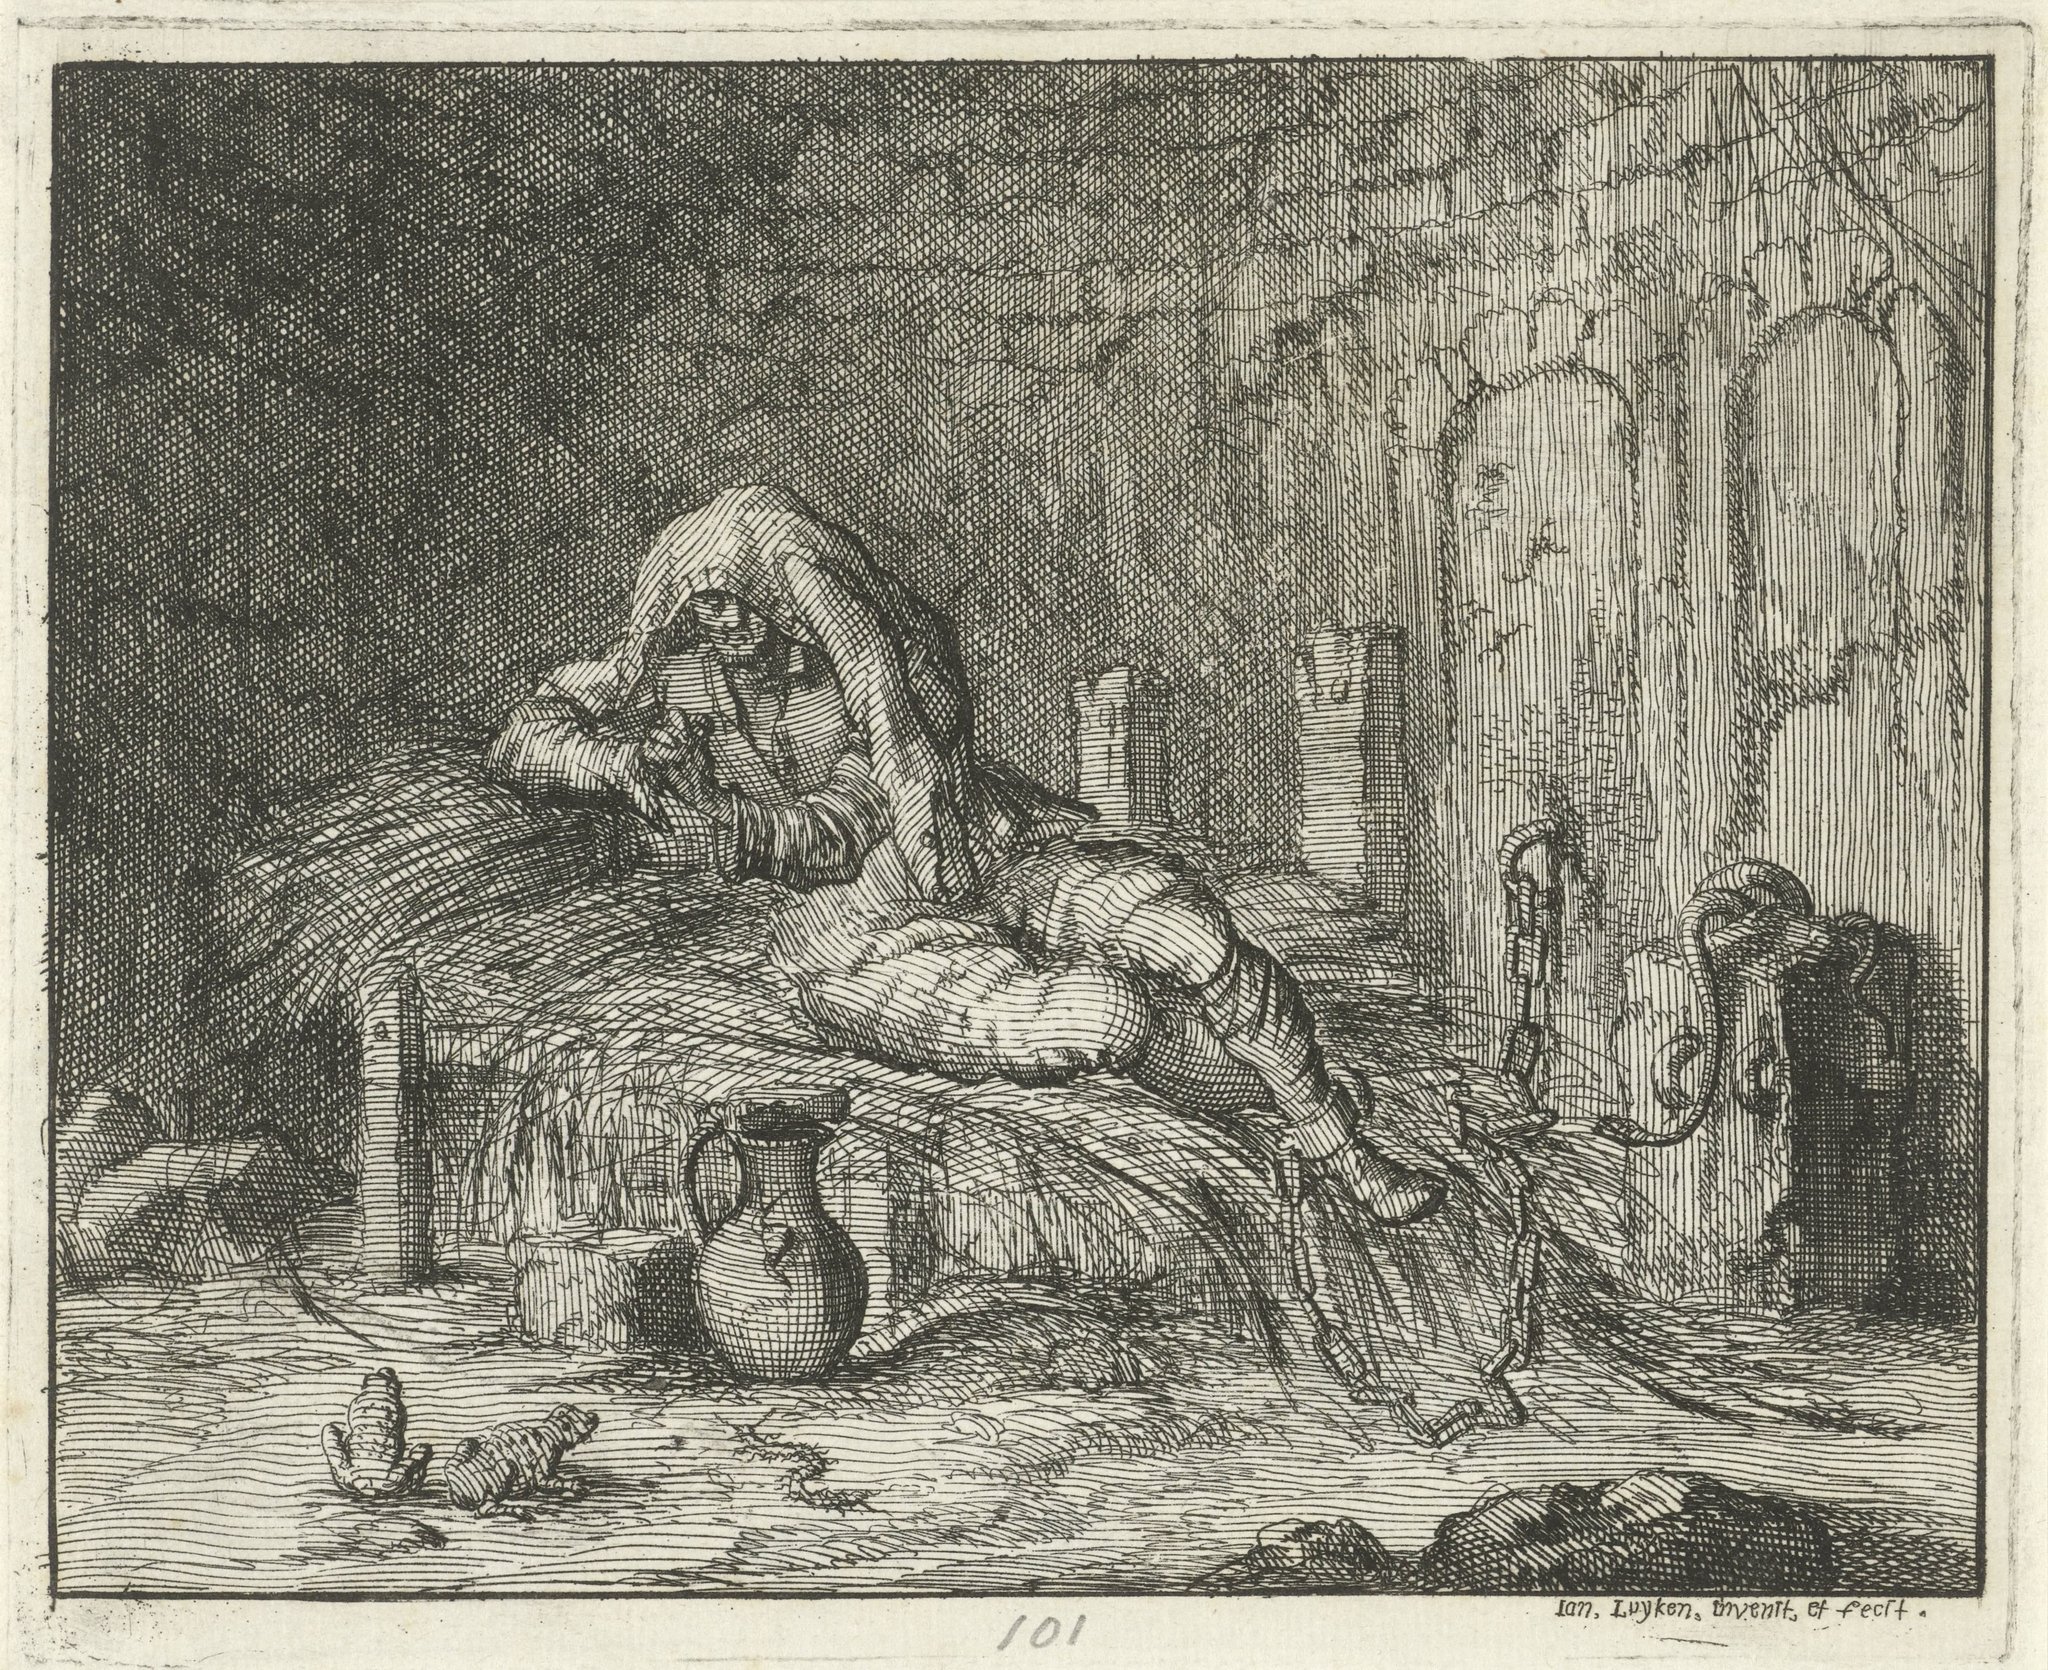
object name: print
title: Georg Wanger in de gevangenis te Bressanone, 1591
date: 1685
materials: paper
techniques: etching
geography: amsterdam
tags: prison, jail, persecution of heretics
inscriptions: number: ‘101’, collector's mark: Lugt 2228